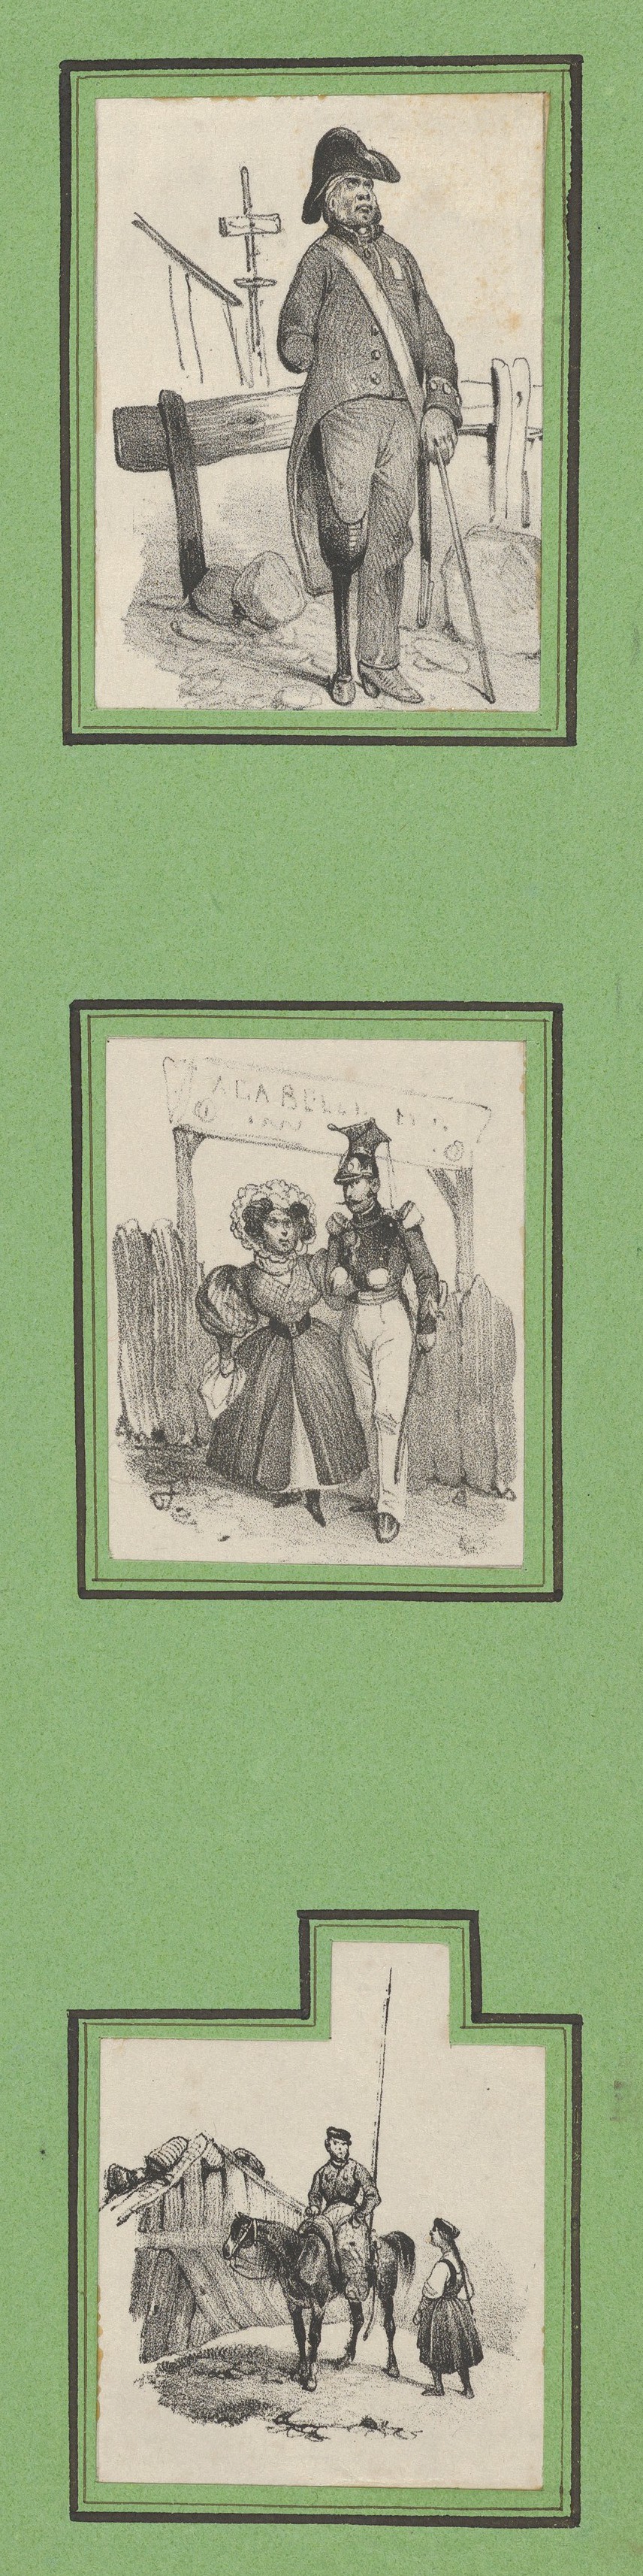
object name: print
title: Soldiers (3 prints of varying size pasted onto a green sheet)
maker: victor adam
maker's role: artist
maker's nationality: french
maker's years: 1801-1866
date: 1834-1866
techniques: lithograph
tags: soldiers,men,women,horses